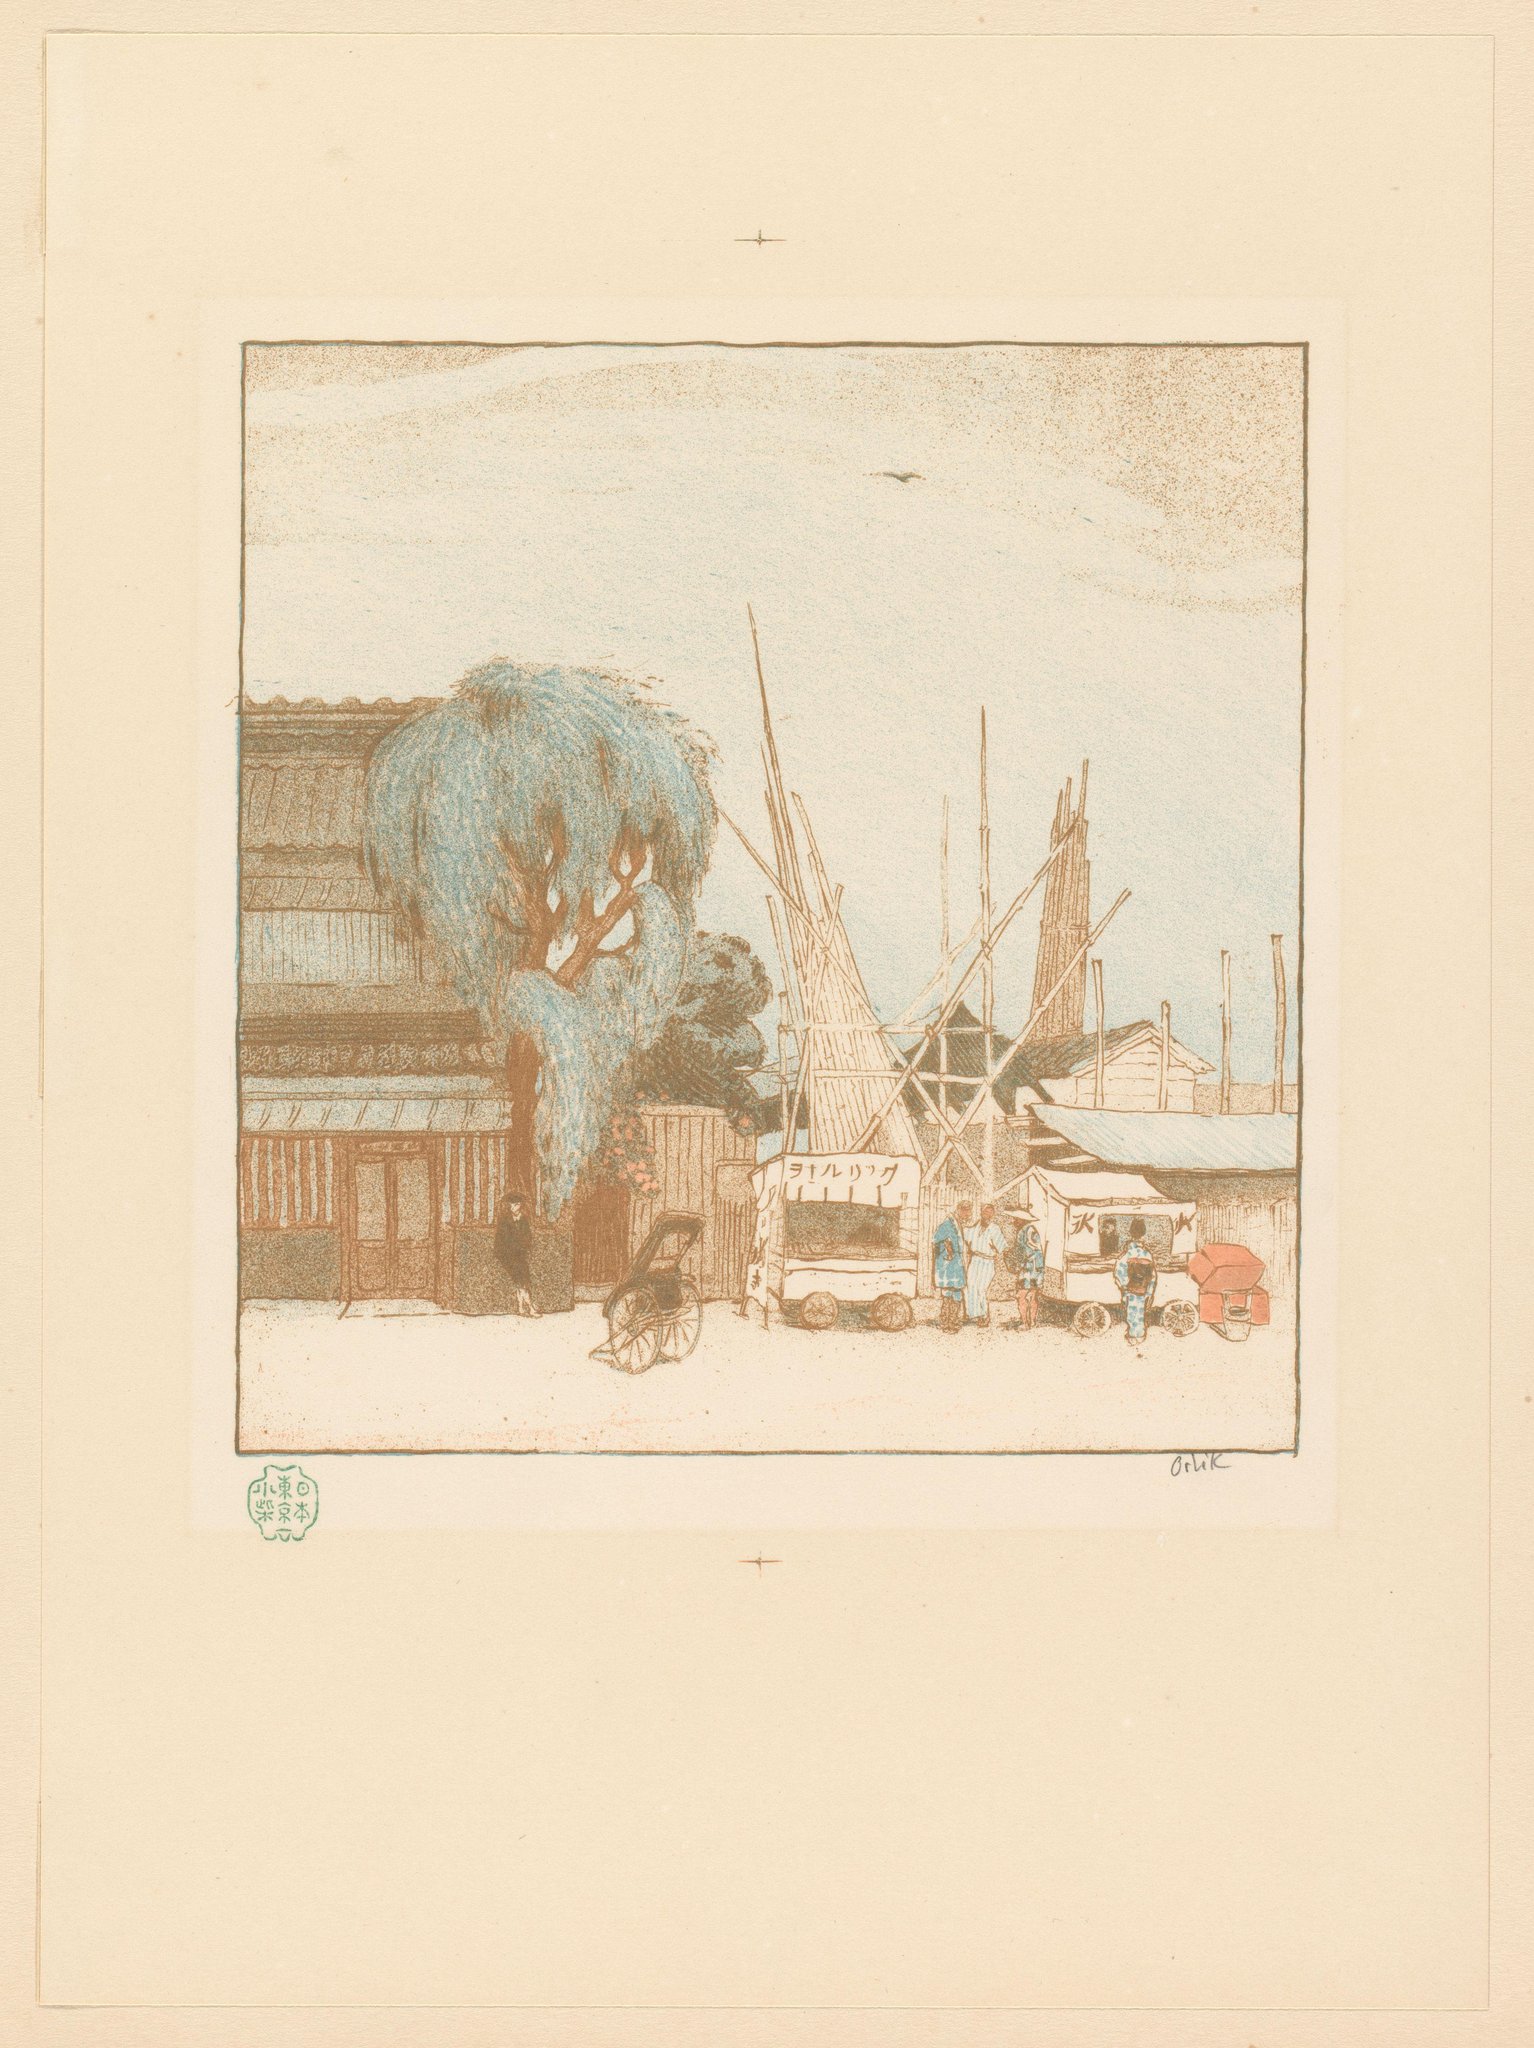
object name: print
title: Uit Japan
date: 1901-1903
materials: paper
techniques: lithograph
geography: tokyo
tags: rickshaw, street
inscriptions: collector's mark: Lugt 2228, workshop stamp: ‘Nihon Tokyo Koshiba’